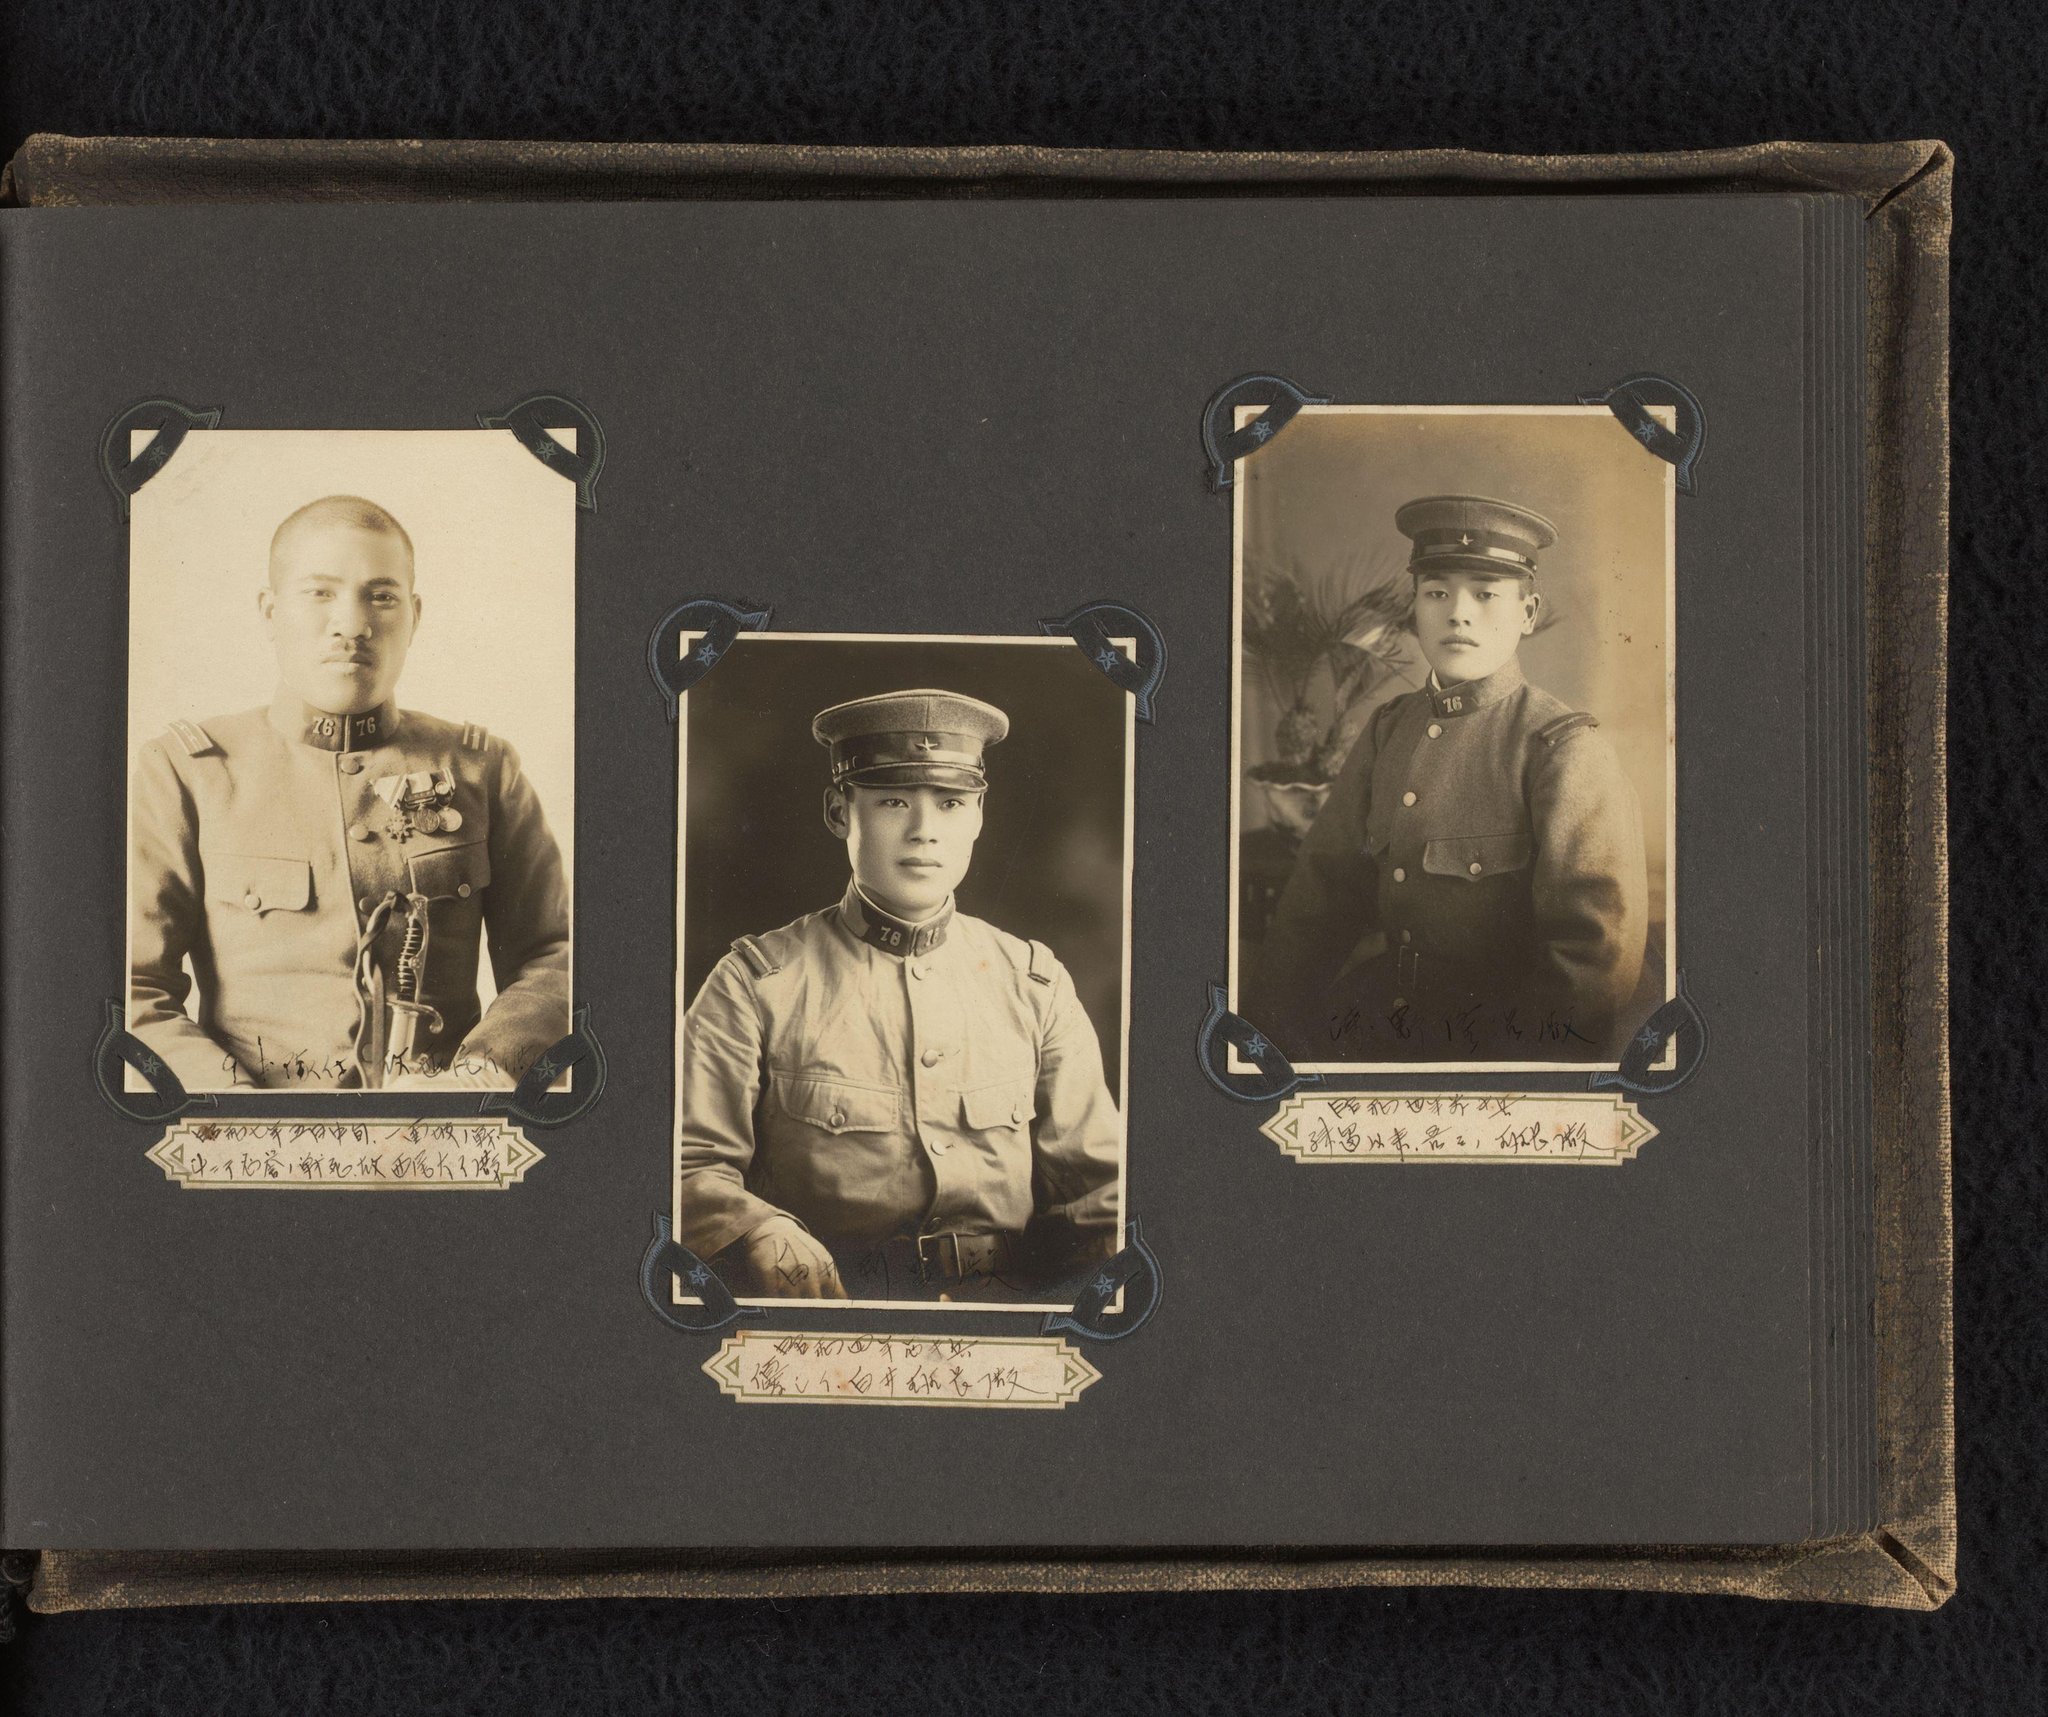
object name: photograph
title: Drie portretten van onbekende Japanse soldaten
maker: Anonymous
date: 1930-1940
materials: paper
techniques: gelatin silver print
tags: anonymous historical person portrayed, the soldier; the soldier's life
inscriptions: inscription: ‘[...]’, inscription: ‘[...]’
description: Deze foto's zijn onderdeel van een album.